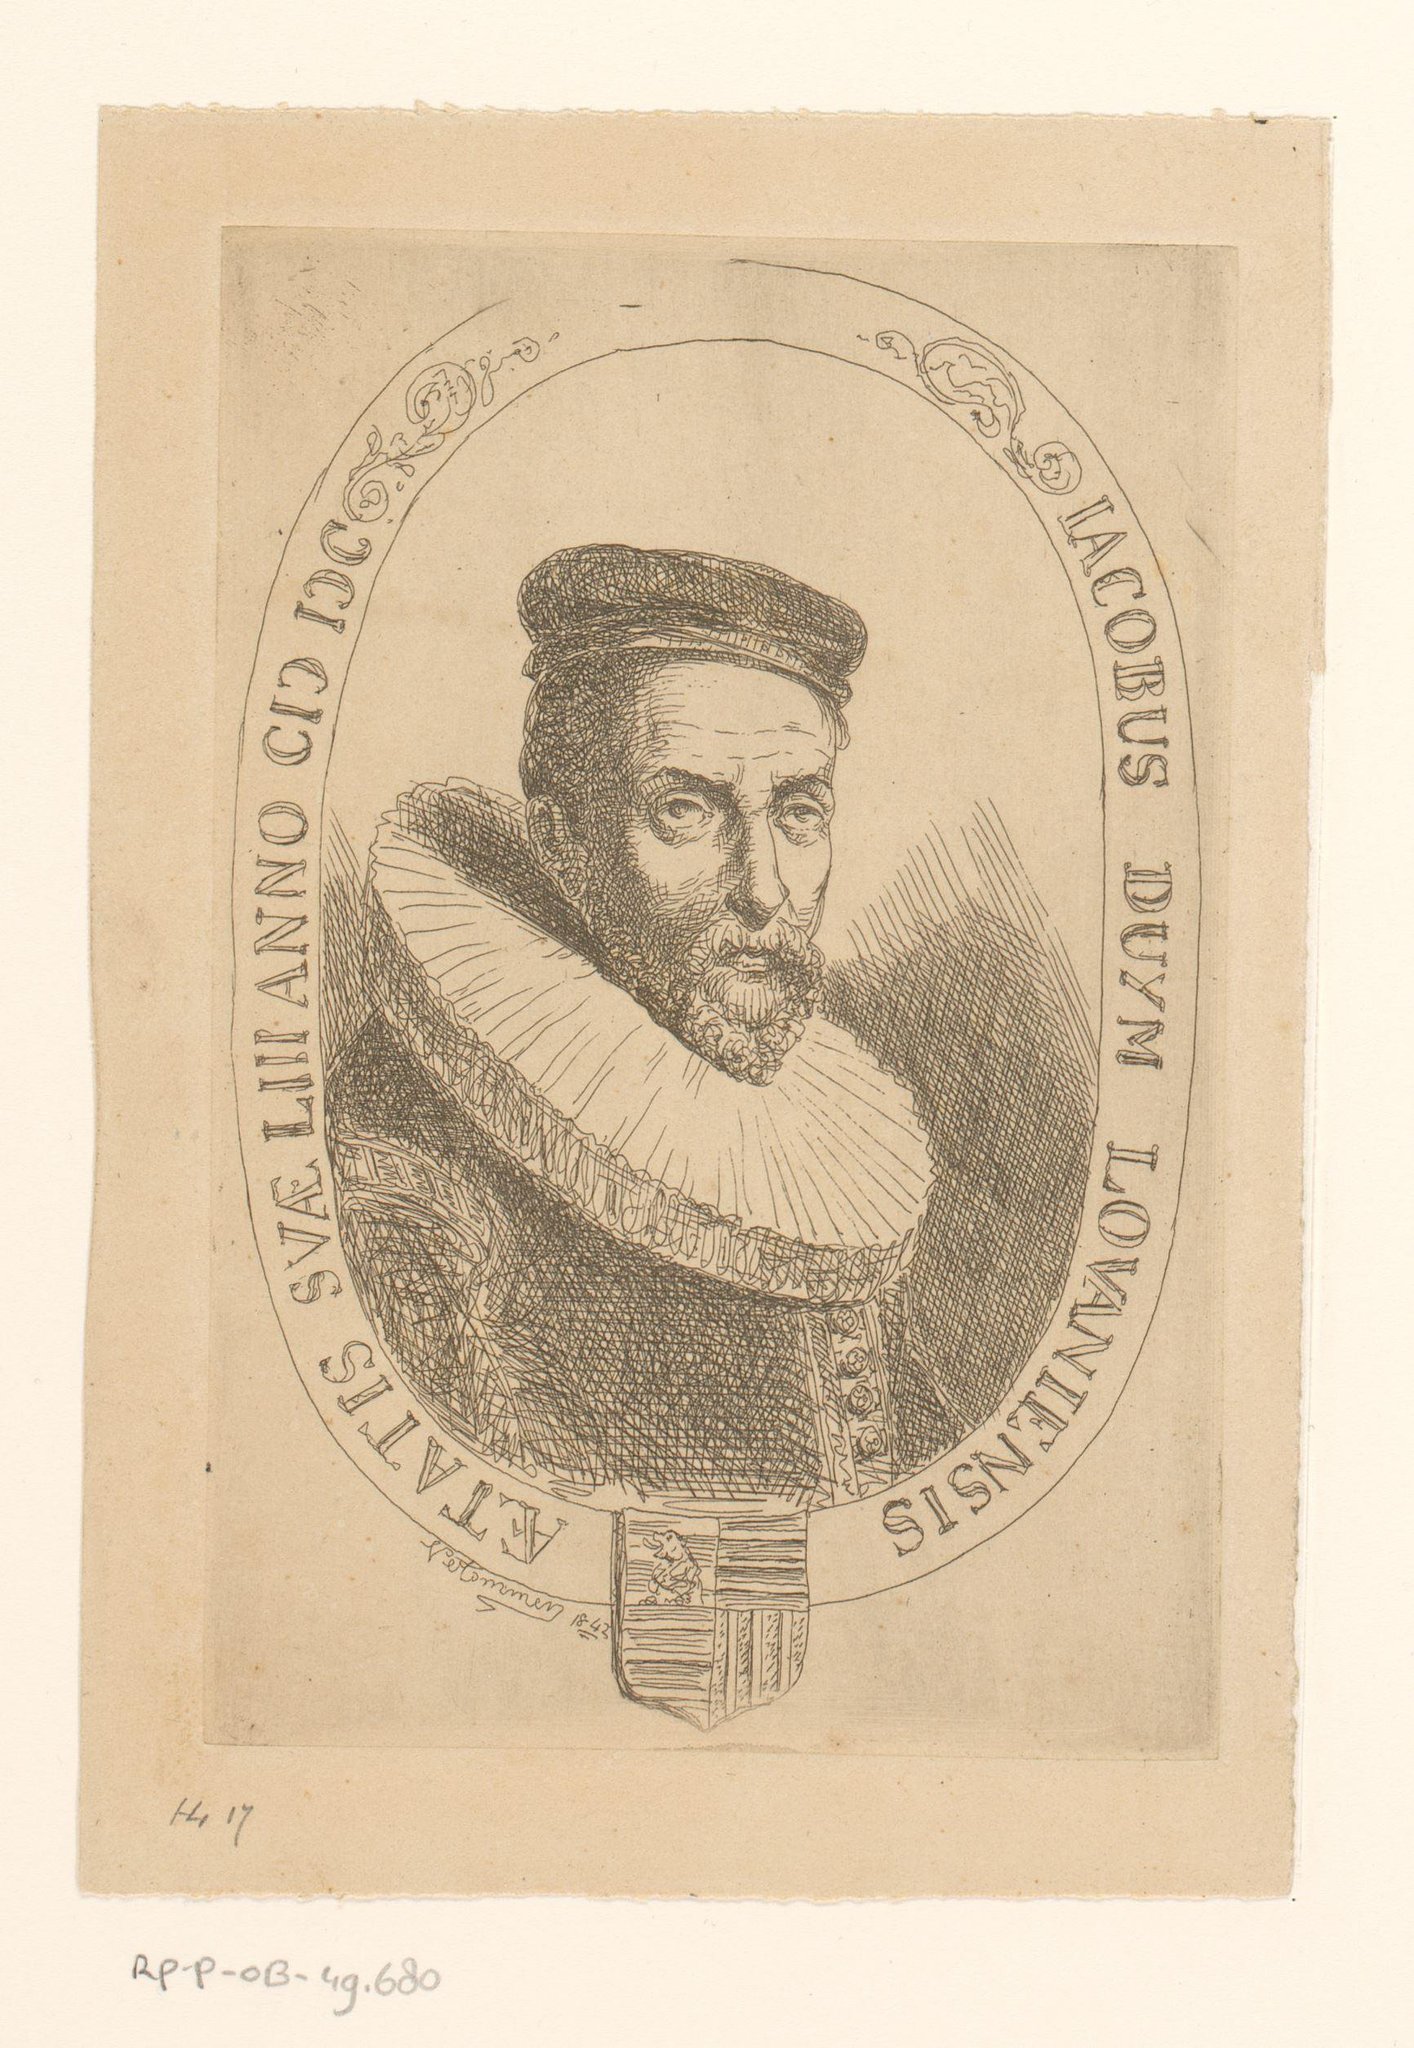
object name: print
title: Portret van Jacob Duym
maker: guillaume joseph vertommen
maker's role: print maker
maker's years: 1815-1863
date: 1842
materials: paper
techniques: etching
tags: historical persons, beard, armorial bearing, heraldry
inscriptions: collector's mark: Lugt 2228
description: Rondom het portret de tekst: Iacobus Duym Lovaniensis aetatis suae LIII anno [...]. Midden onder het familiewapen.